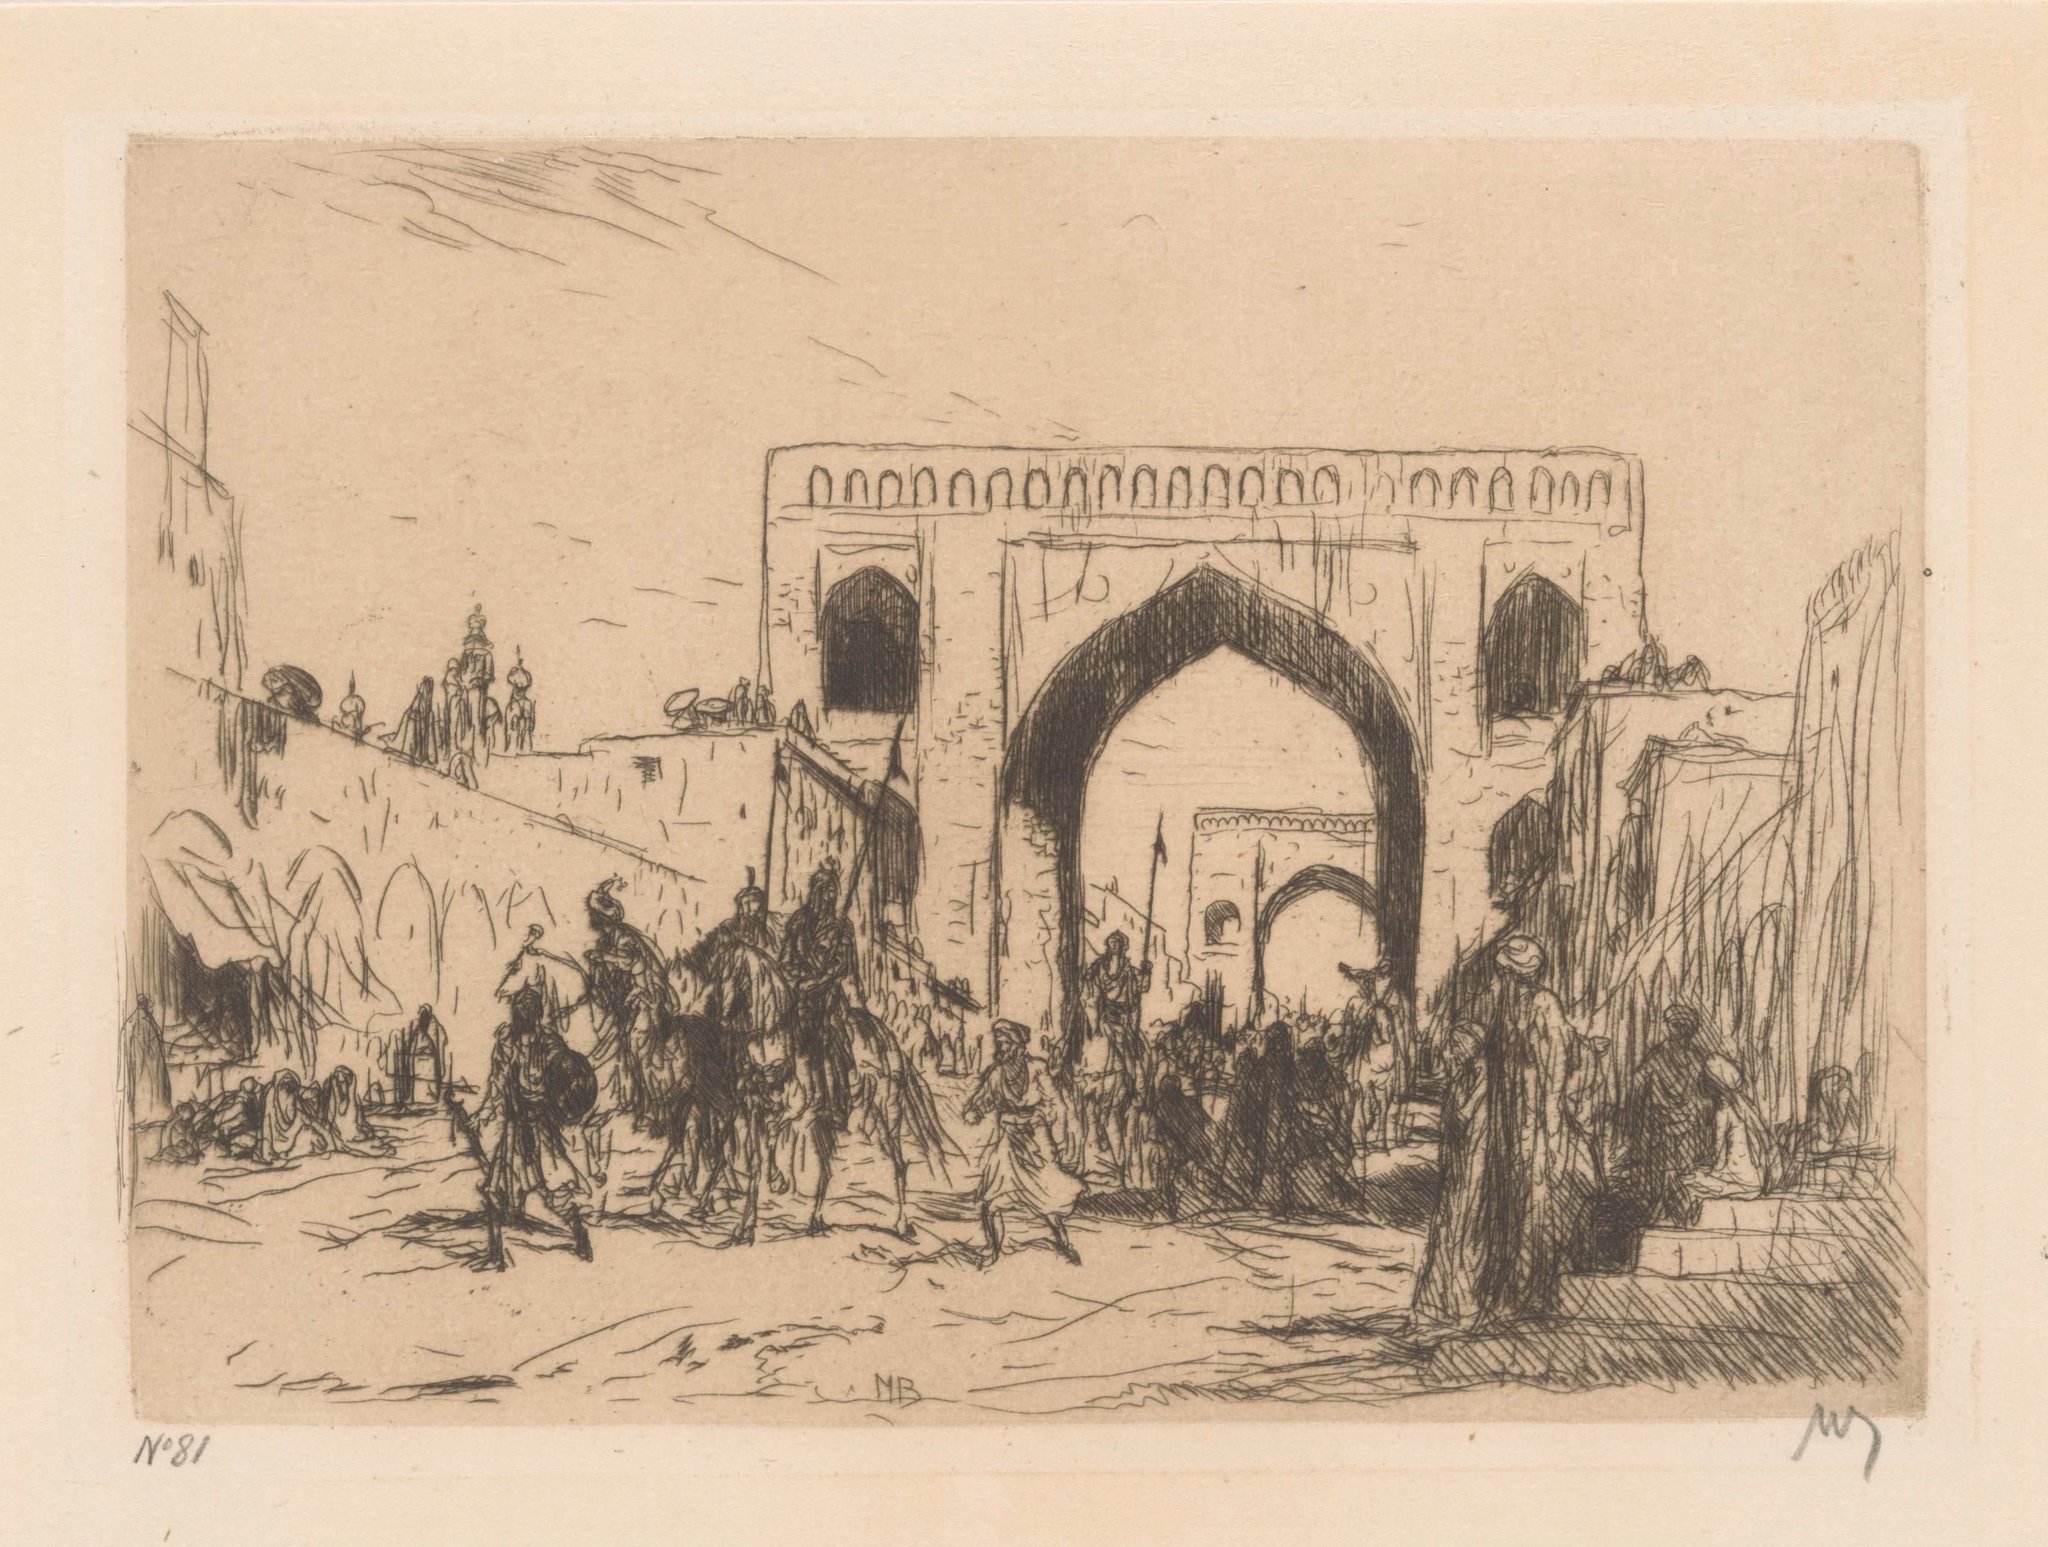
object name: print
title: Twee stadspoorten in Hyderabad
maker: marius bauer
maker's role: draughtsman, print maker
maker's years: 1867-1932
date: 1899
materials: paper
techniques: etching, intaglio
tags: riding a horse, ass, or mule; rider, horseman, city-gate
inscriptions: collector's mark: Lugt 2228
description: Een straat met twee stadspoorten in Hyderabad in Brits-Indië. Op straat verschillende ruiters te paard.